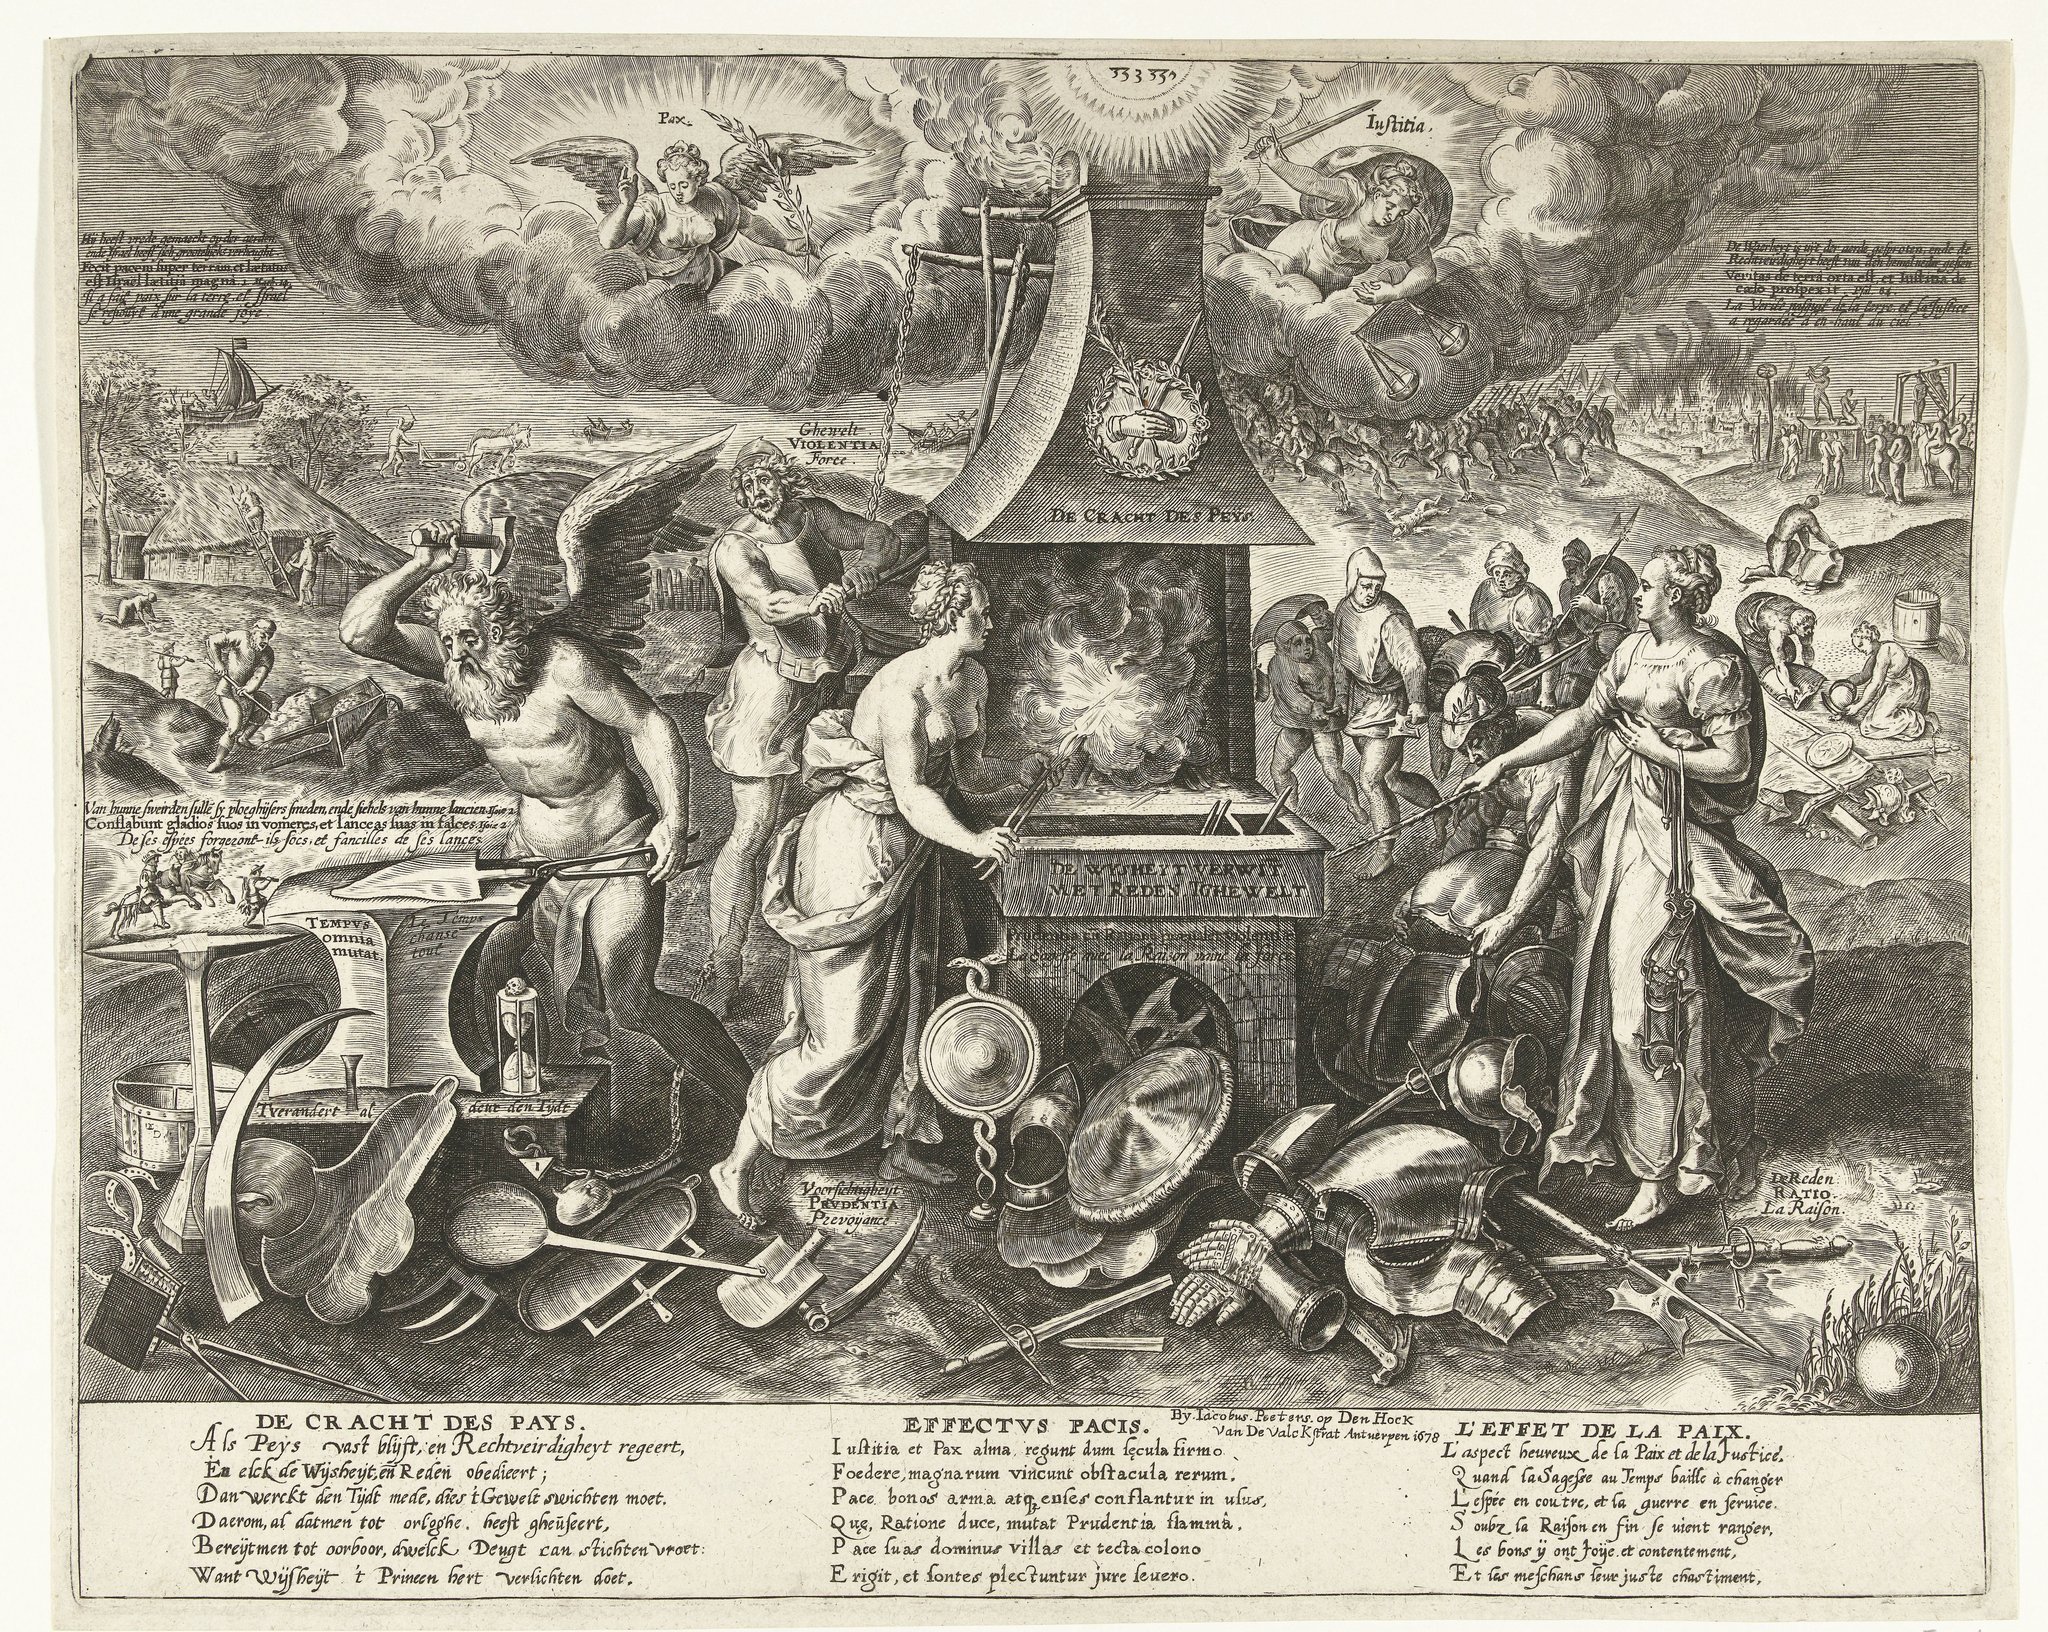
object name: propagandaprent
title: De kracht van de vrede, 1678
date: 1577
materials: paper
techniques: engraving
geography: antwerp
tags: symbols, allegories of peace, 'pax'; 'pace' (ripa), isaiah's prophecy of the swords beaten into plough-shares, smith, blacksmith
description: Zinneprent op de Vrede van Nijmegen gesloten tussen de Republiek en Frankrijk op 10 augustus 1678. De Voorzichtigheid (Prudentia), Reden (Ratio) en Tijd (Tempus) smeden de wapens van de oorlog om tot ploegscharen en andere werktuigen. Geweld (Violentia) bedient de blaasbalg van de oven. In de hemel Vrede (Pax) en Rechtvaardigheid (Justitia). In en onder de voorstelling opschriften en verzen in het Nederlands, Latijn en Frans. De prent is oorspronkelijk vervaardigd ter gelegenheid van het Eeuwig Edict in 1577 en eerder ook al aangepast om te dienen als allegorie op de Vrede van Munster in 1648.